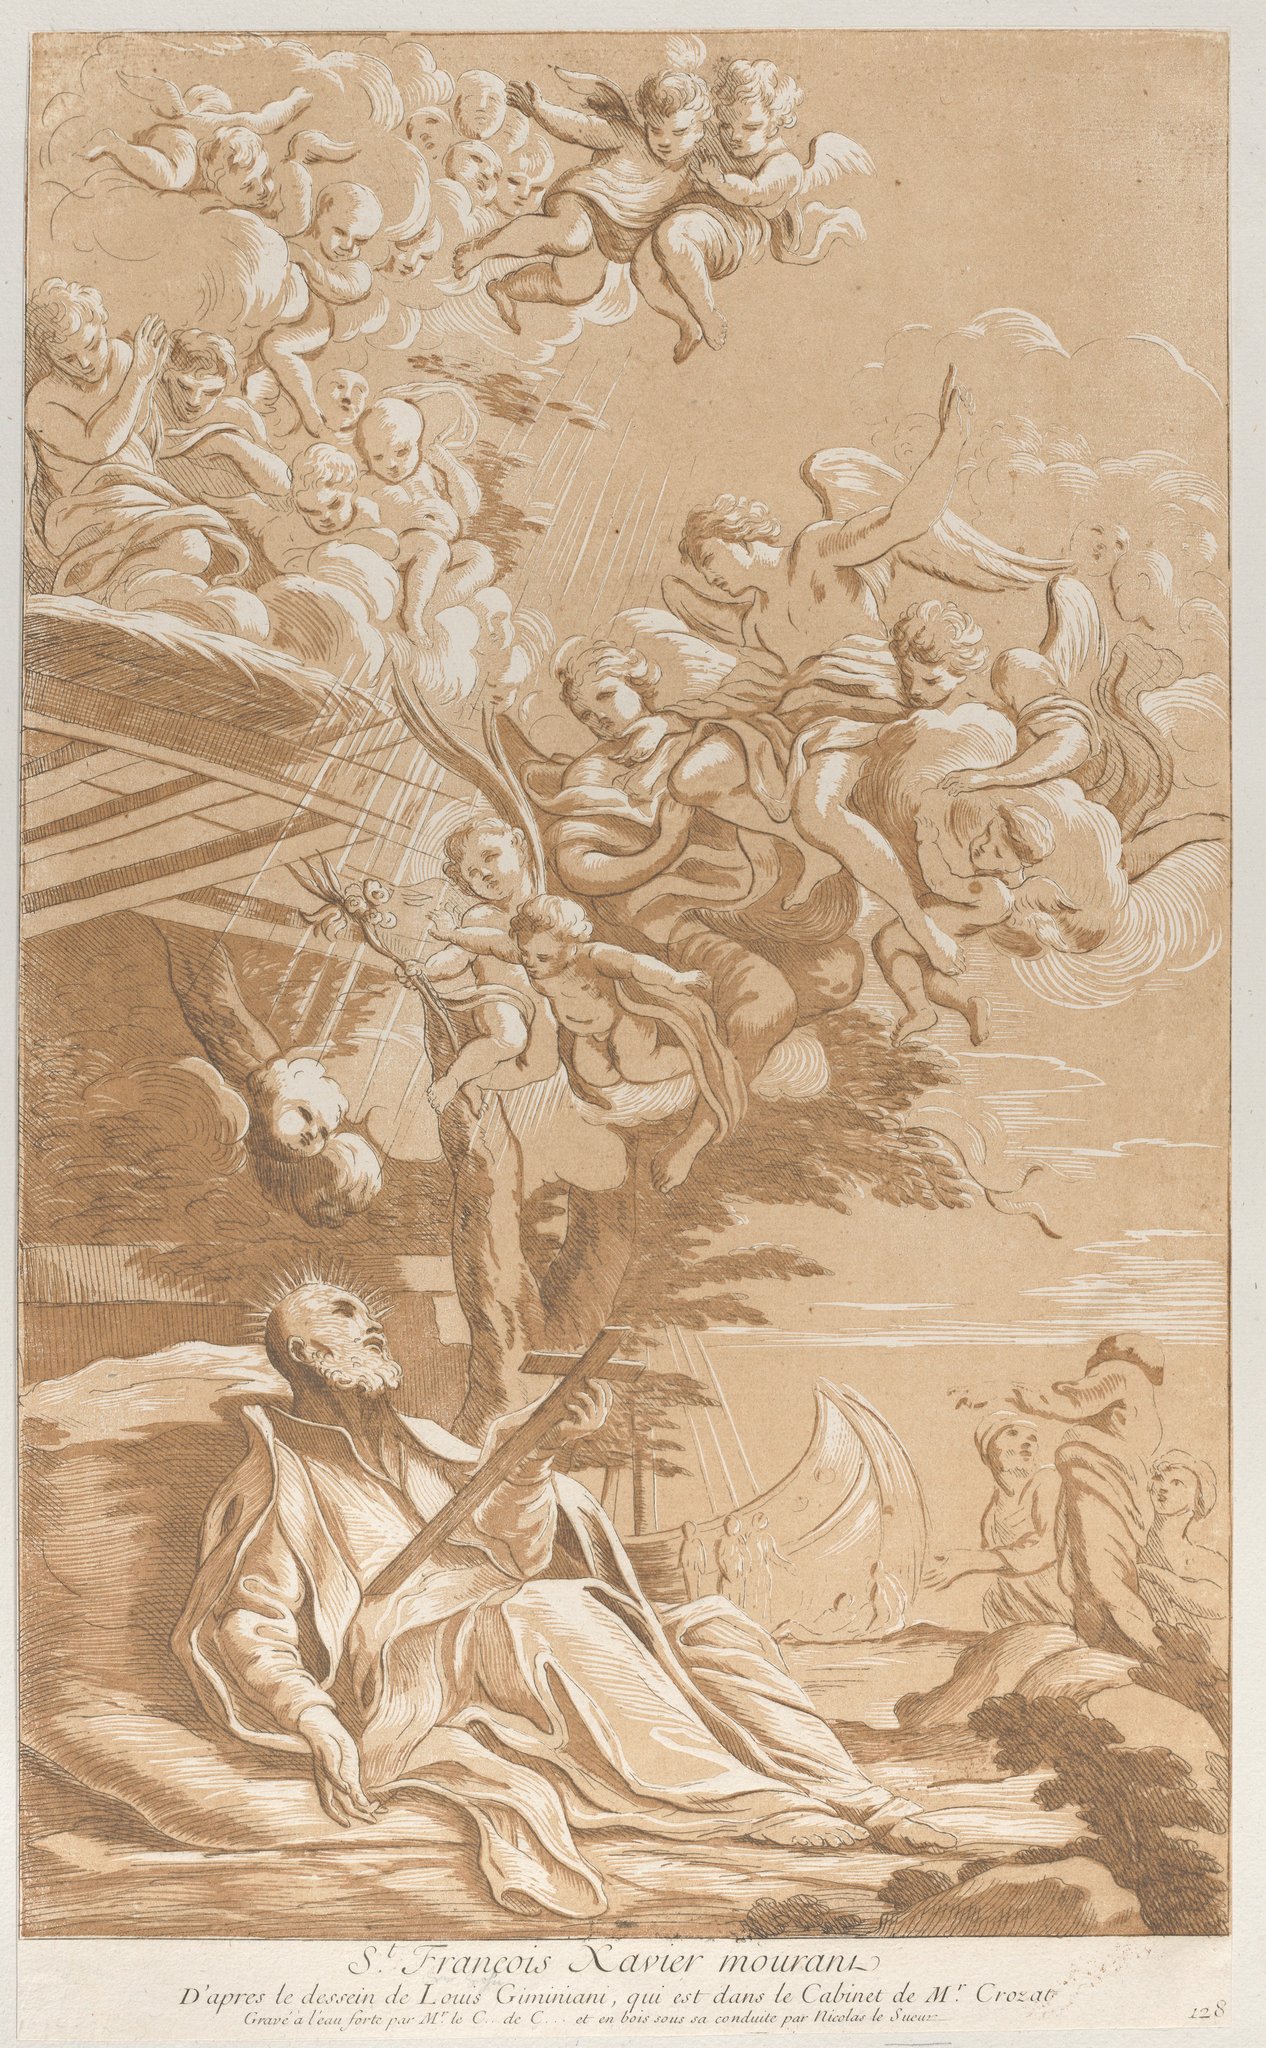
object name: print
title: Death of Saint Francis Xavier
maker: giacinto gimignani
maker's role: artist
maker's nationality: italian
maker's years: 1606-1681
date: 1729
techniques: aquatint, etching, printing